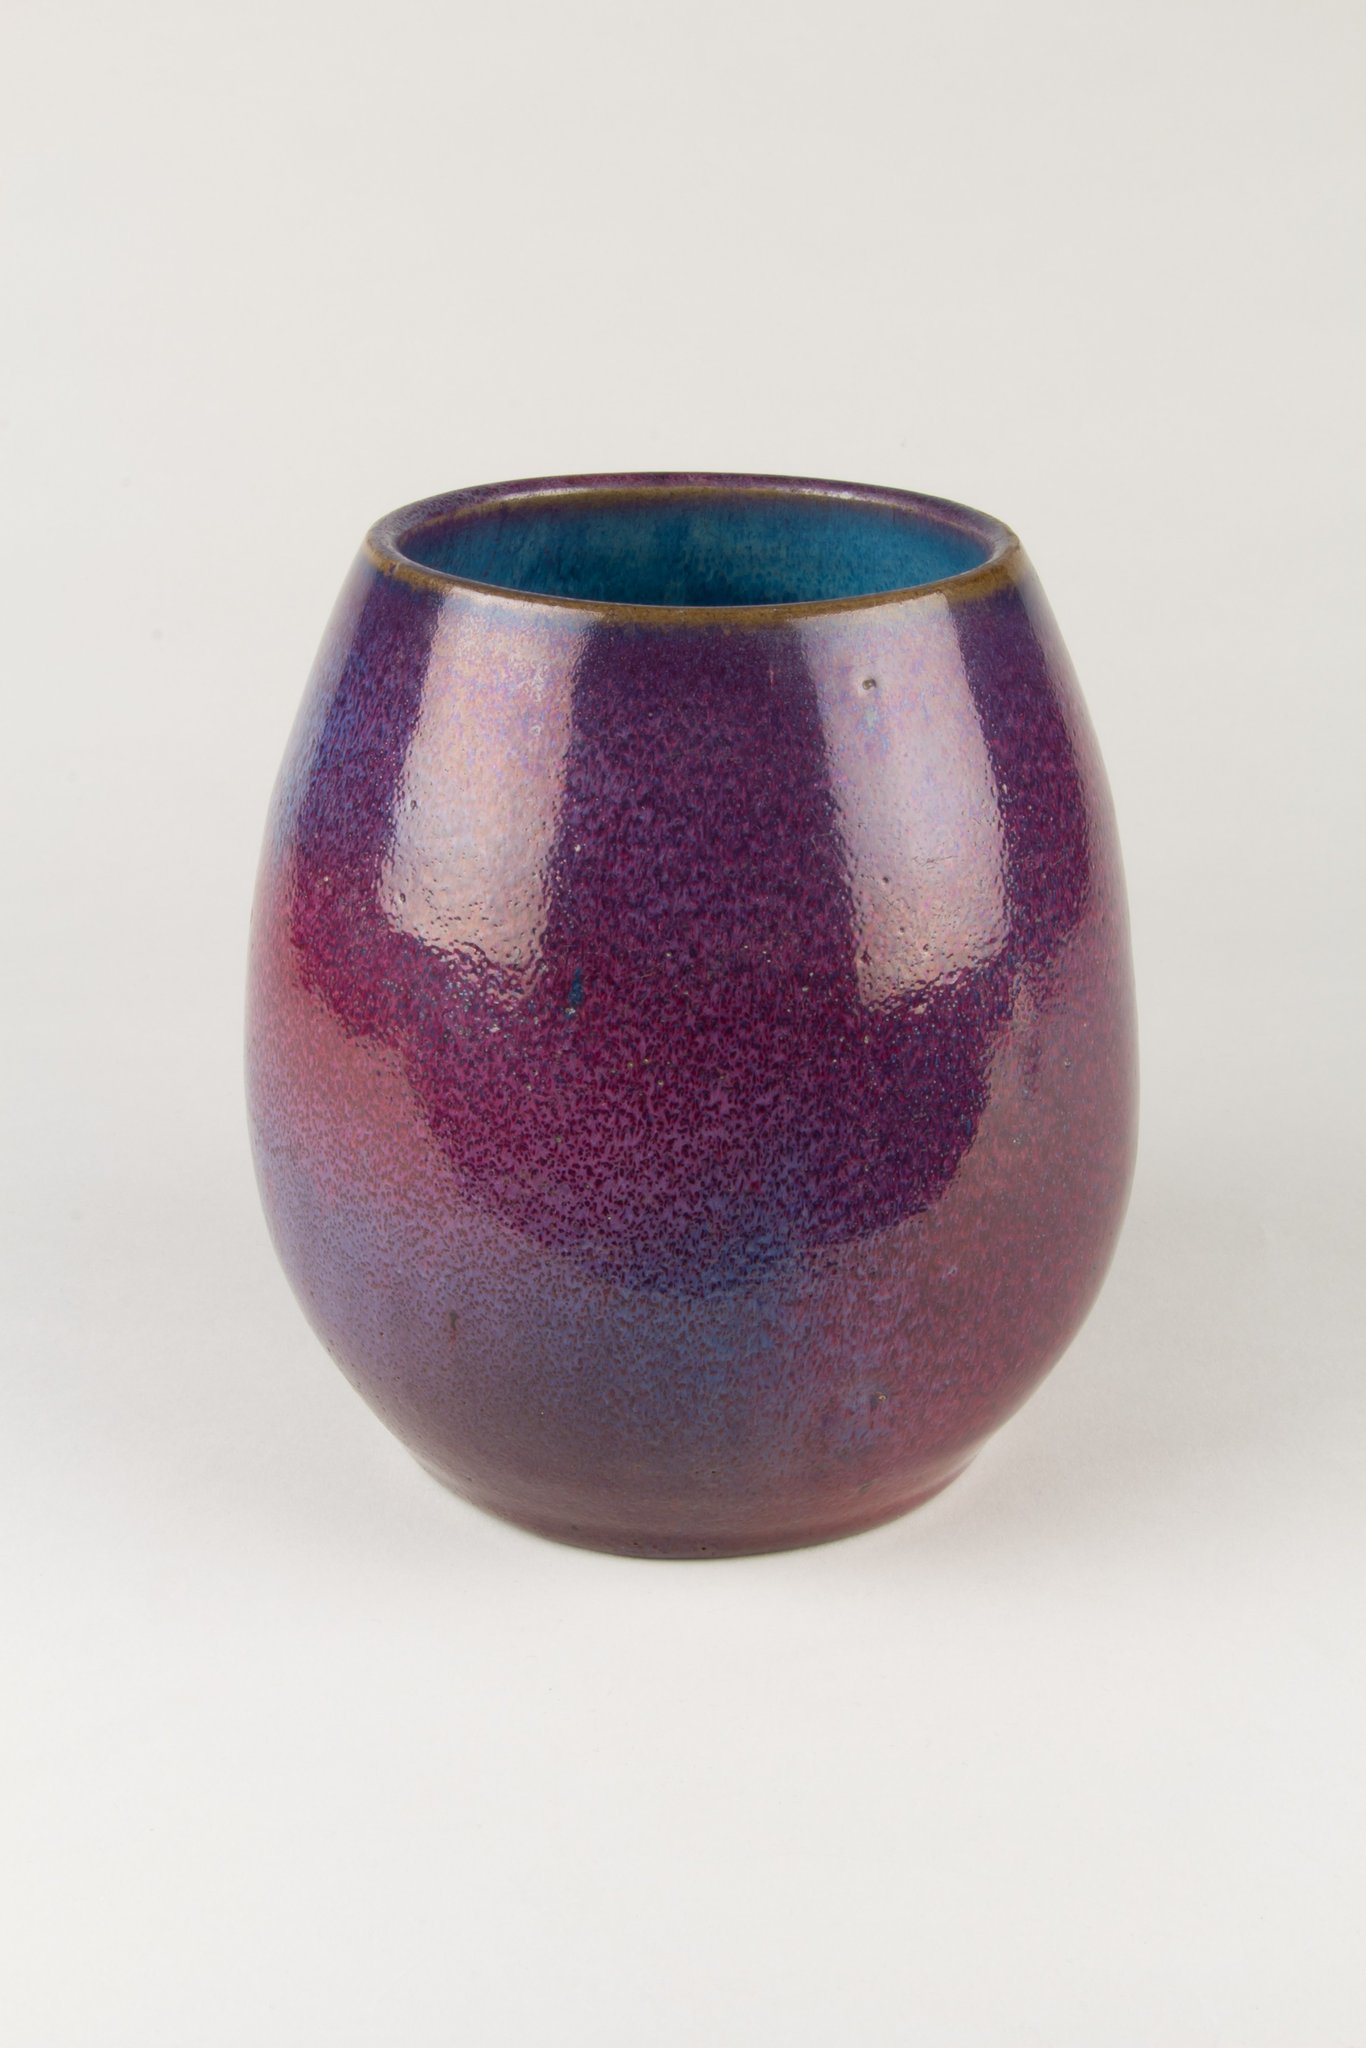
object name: vase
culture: chinese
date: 960-1279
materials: pottery